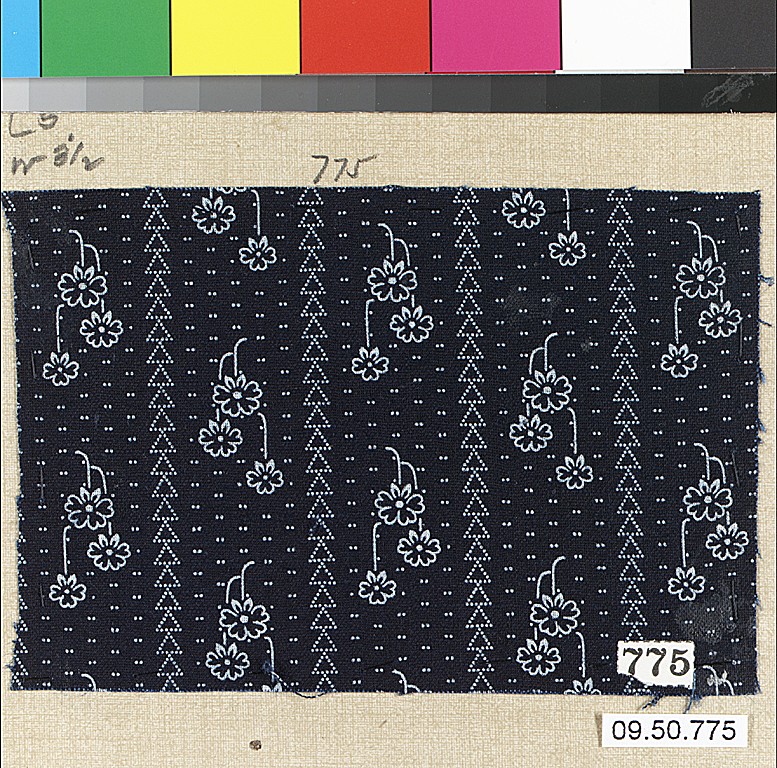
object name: piece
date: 1801-1900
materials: cotton